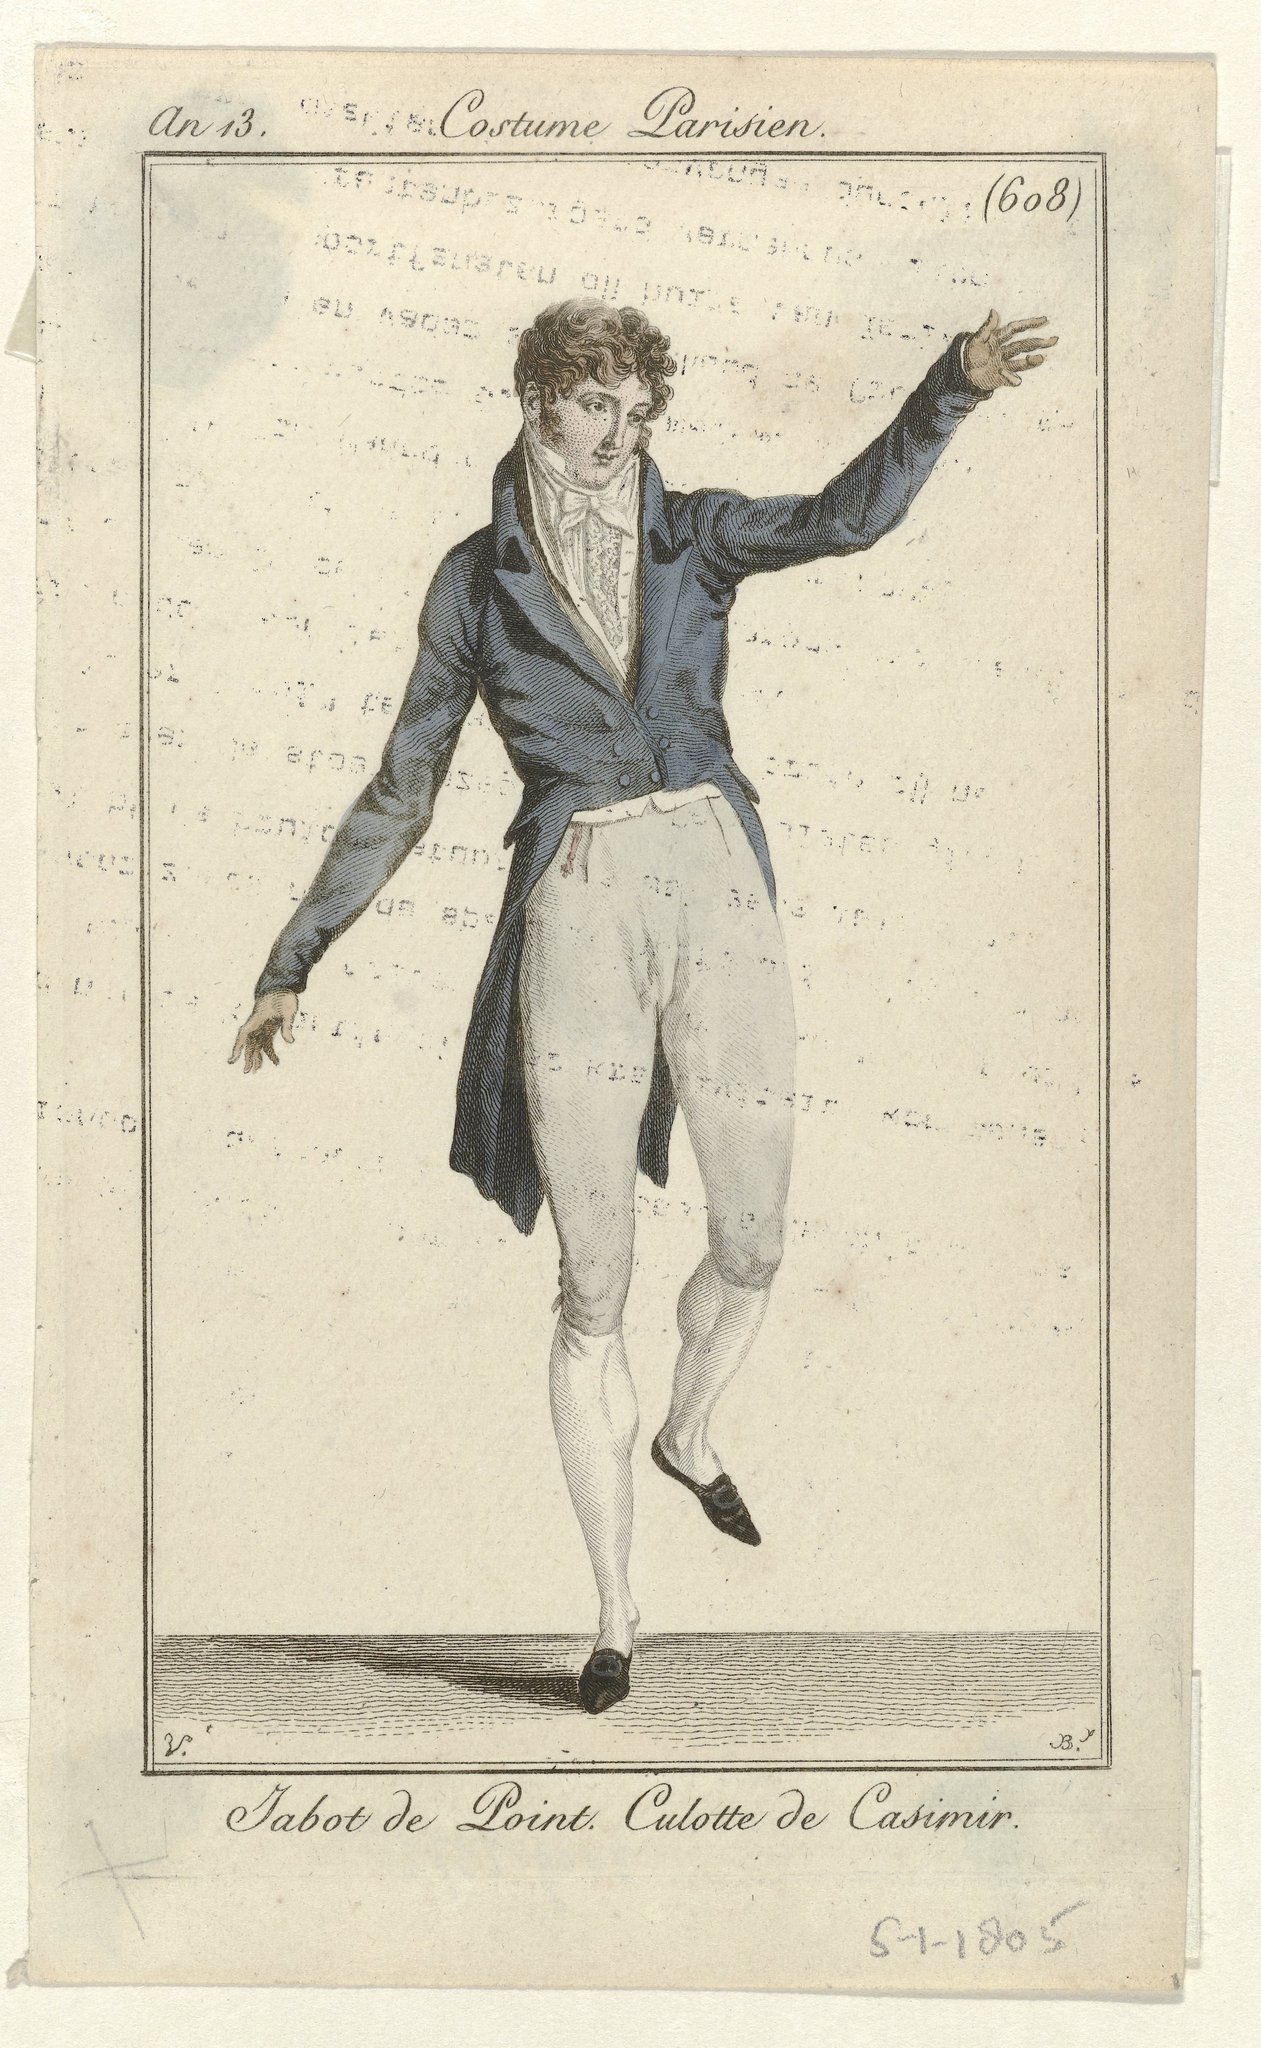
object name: fashion print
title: Journal des Dames et des Modes, Costume Parisien, 5 janvier 1805, An 13, (608): Jabot de Point (...)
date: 1805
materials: paper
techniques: engraving, hand coloring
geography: paris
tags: clothing for the upper part of the body (vest) (+ men's clothes), neck-gear ~ clothing (cravat) (+ men's clothes), coat (+ men's clothes), fashion plates, shoes, sandals (+ men's clothes), trousers, breeches, etc. (breeches) (+ men's clothes), gloves, mittens, etc. (+ men's clothes), stockings, socks (+ men's clothes)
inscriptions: title: ‘Costume Parisien.’, caption: ‘Jabot de Point. Culotte de Casimir.’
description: Dansende man gekleed in een frak met revers, vest en hemd met 'jabot de point' (kant) op een kniebroek van kasjmier ('casimir'). Cravate en kousen. Accessoires: handschoenen, breloque, platte schoenen met puntige neuzen en vierkante gespen. De prent maakt deel uit van het modetijdschrift Journal des Dames et des Modes, uitgegeven door Pierre de la Mésangère, Parijs, 1797-1839.